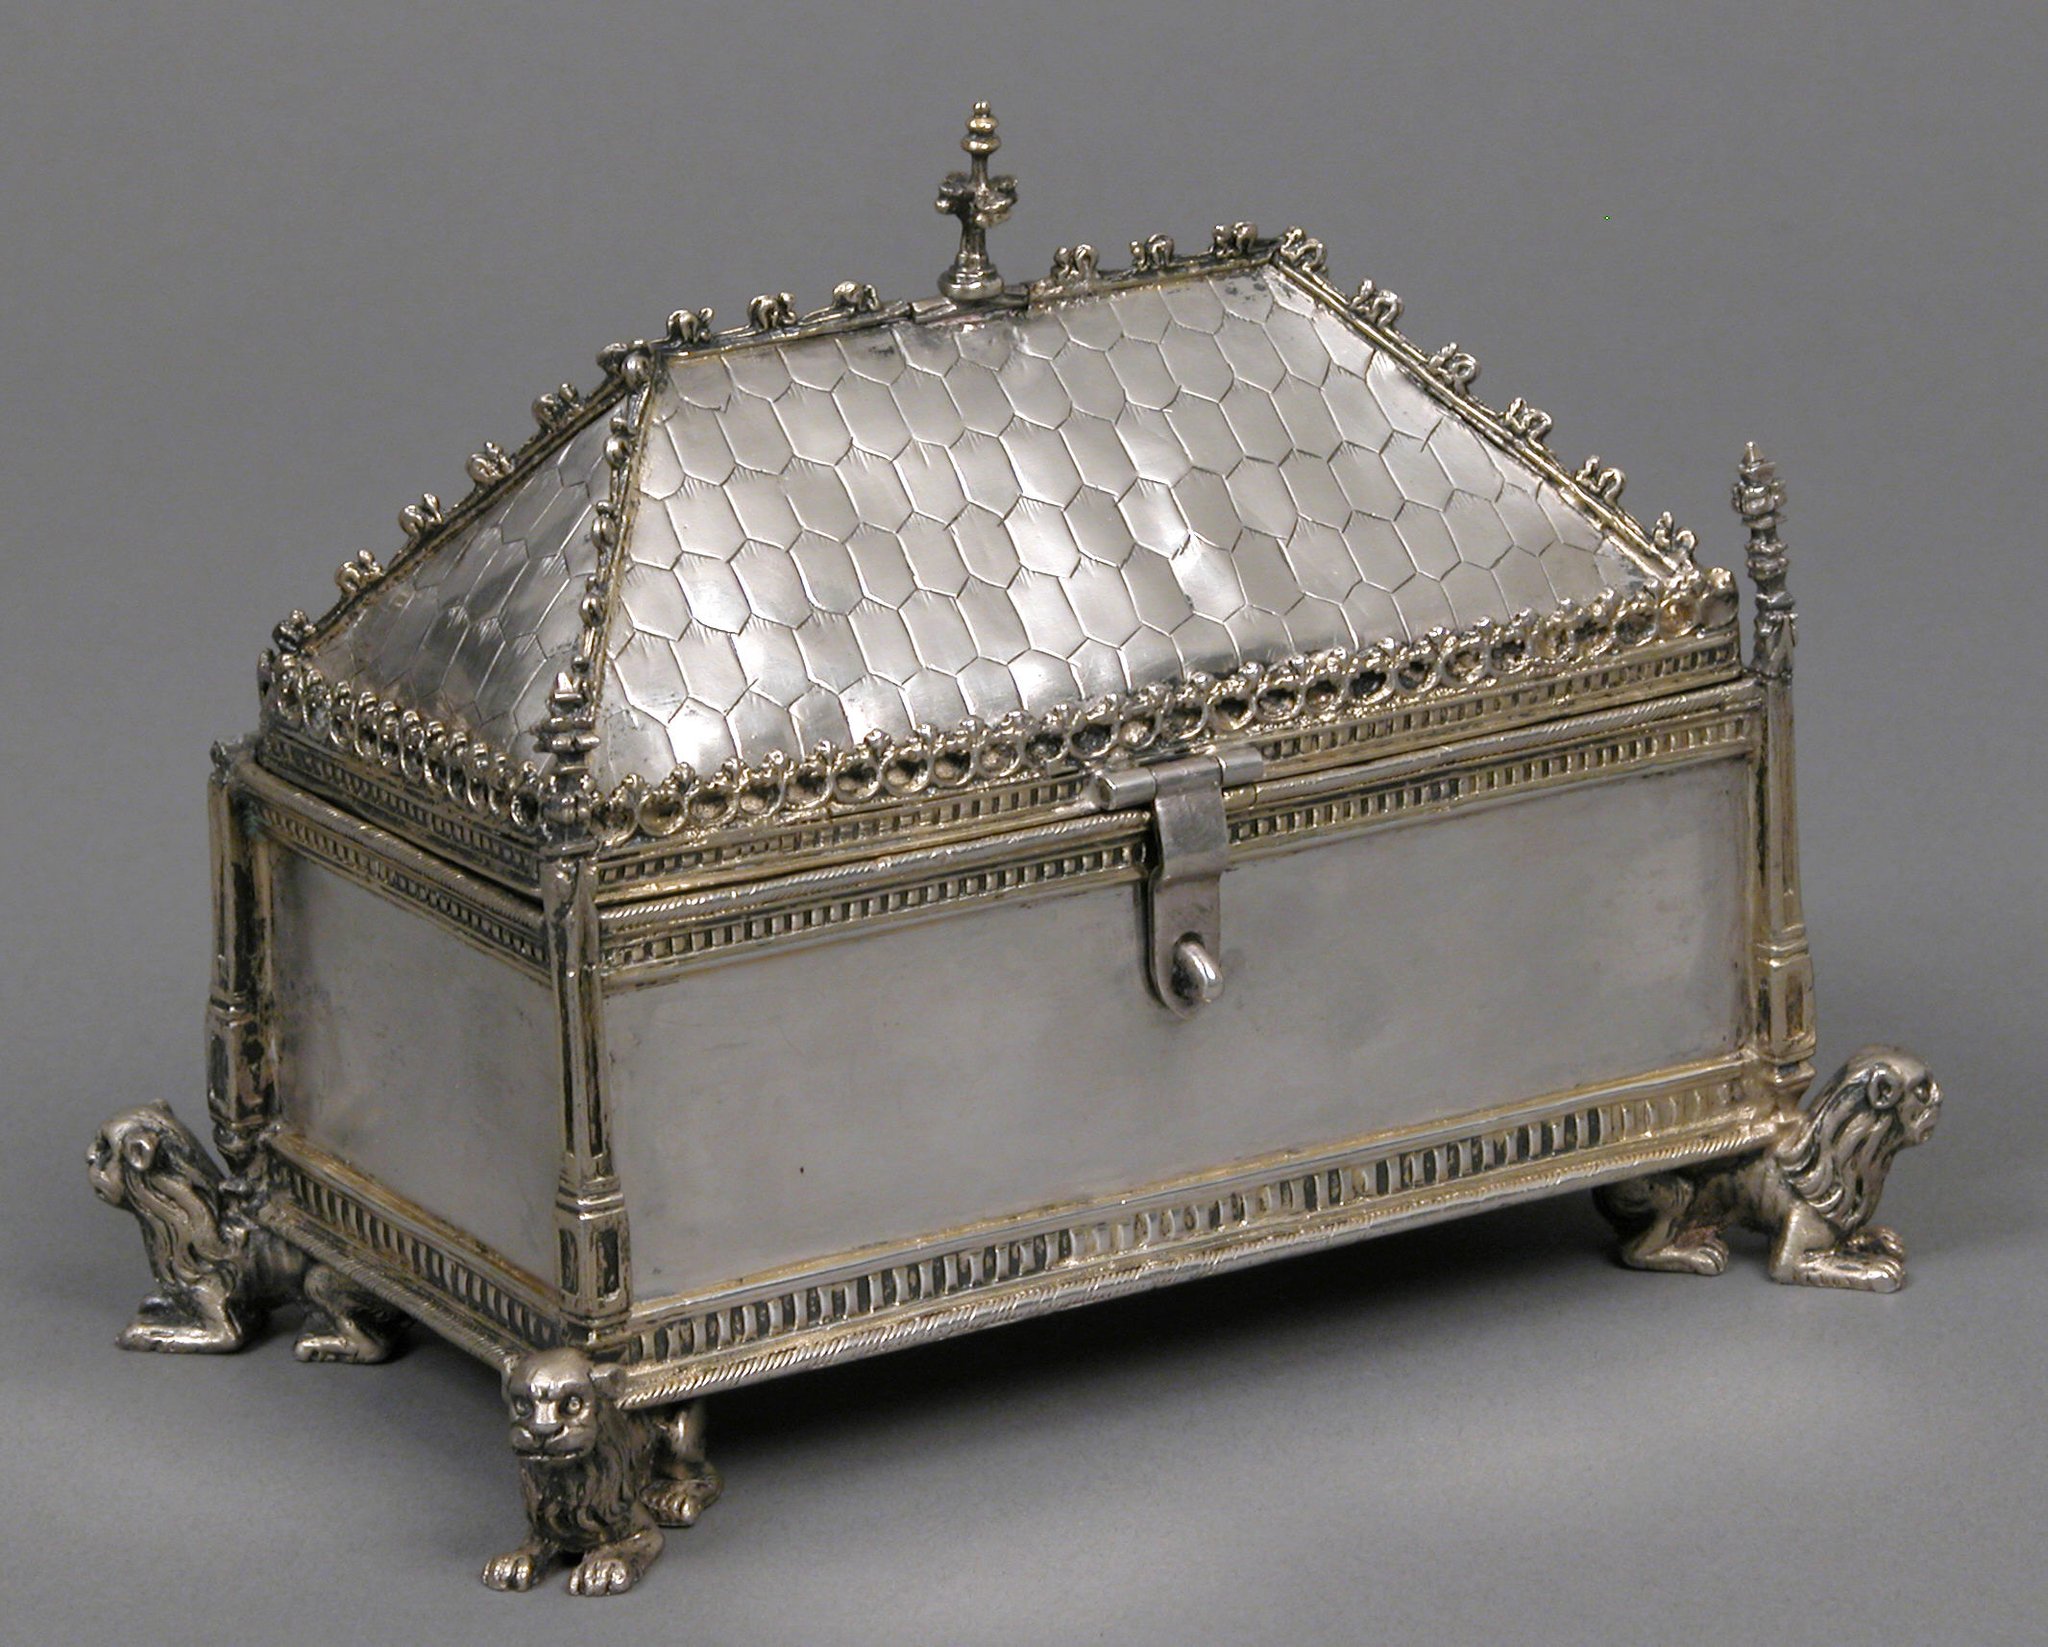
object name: box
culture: french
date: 1401-1500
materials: silver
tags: lions